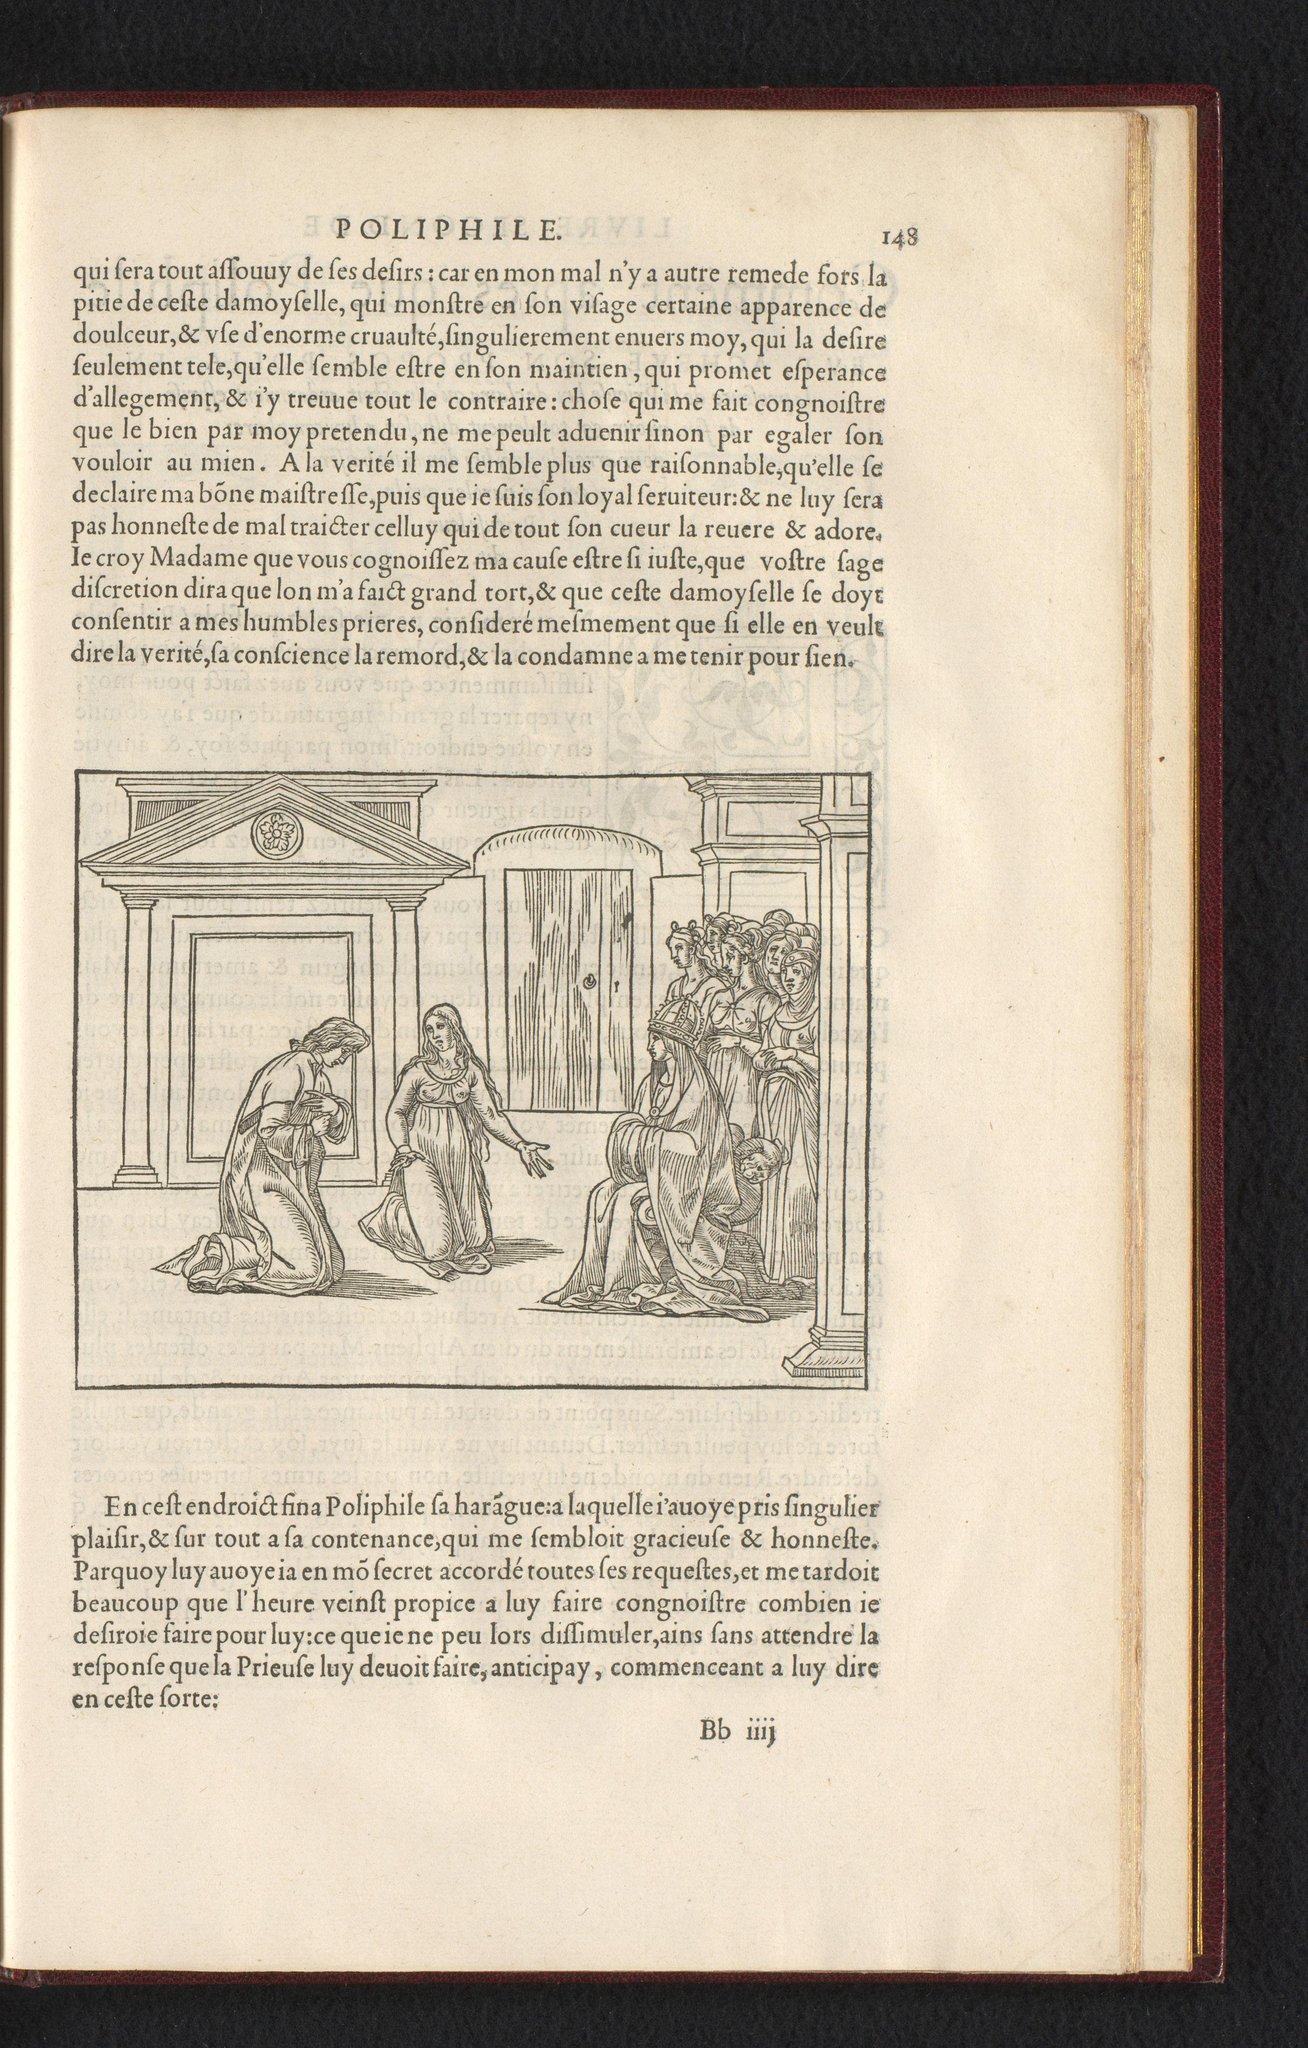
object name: print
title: Polia en Poliphilo voor de priesteres van Venus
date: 1546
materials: paper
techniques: letterpress printing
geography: paris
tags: priest ~ greek religion - ee - priestess, (scenes from) specific works of literature: colonna, hypnerotomachia poliphili, kneeling figure, temple, shrine ~ greek religion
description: Prent uit: Colonna, Francesco. Hypnerotomachie ou discours du songe de Poliphile, deduisant comme amour le combat a l'occasion de Polia. Parijs: Jacques Kerver, 1546, recto fol. 148.